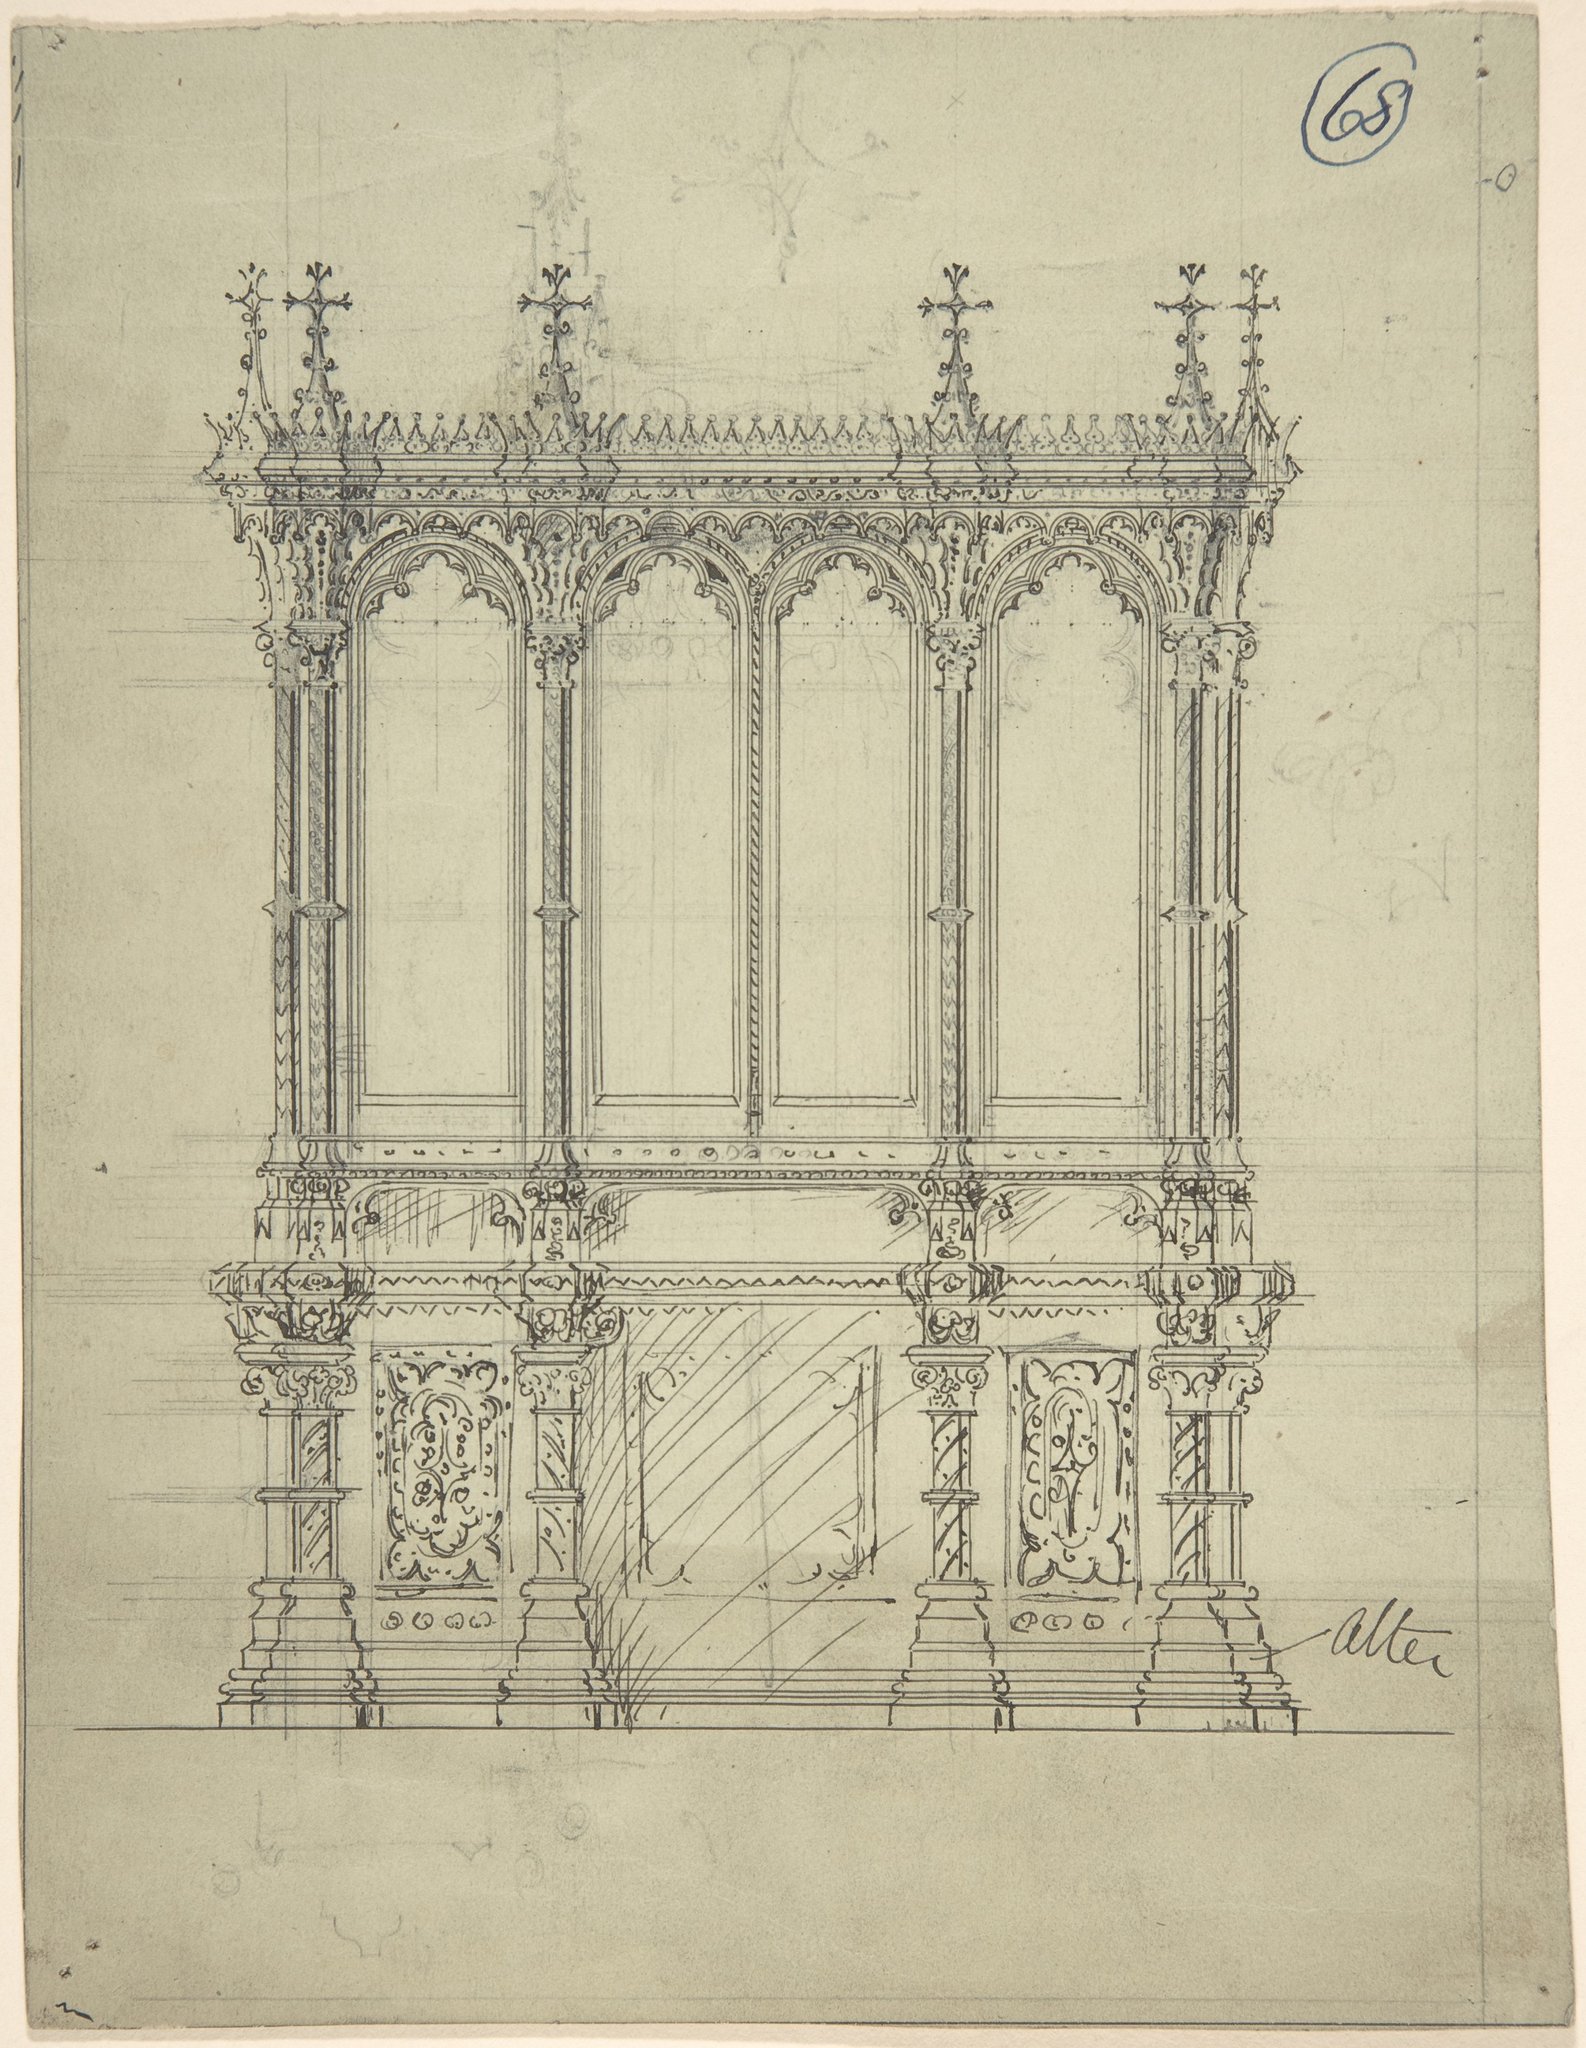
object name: drawing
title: Design for a Gothic Cabinet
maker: charles hindley and sons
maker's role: artist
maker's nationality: british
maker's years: 1841-1917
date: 1841-1884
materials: graphite, ink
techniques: pen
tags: cabinets